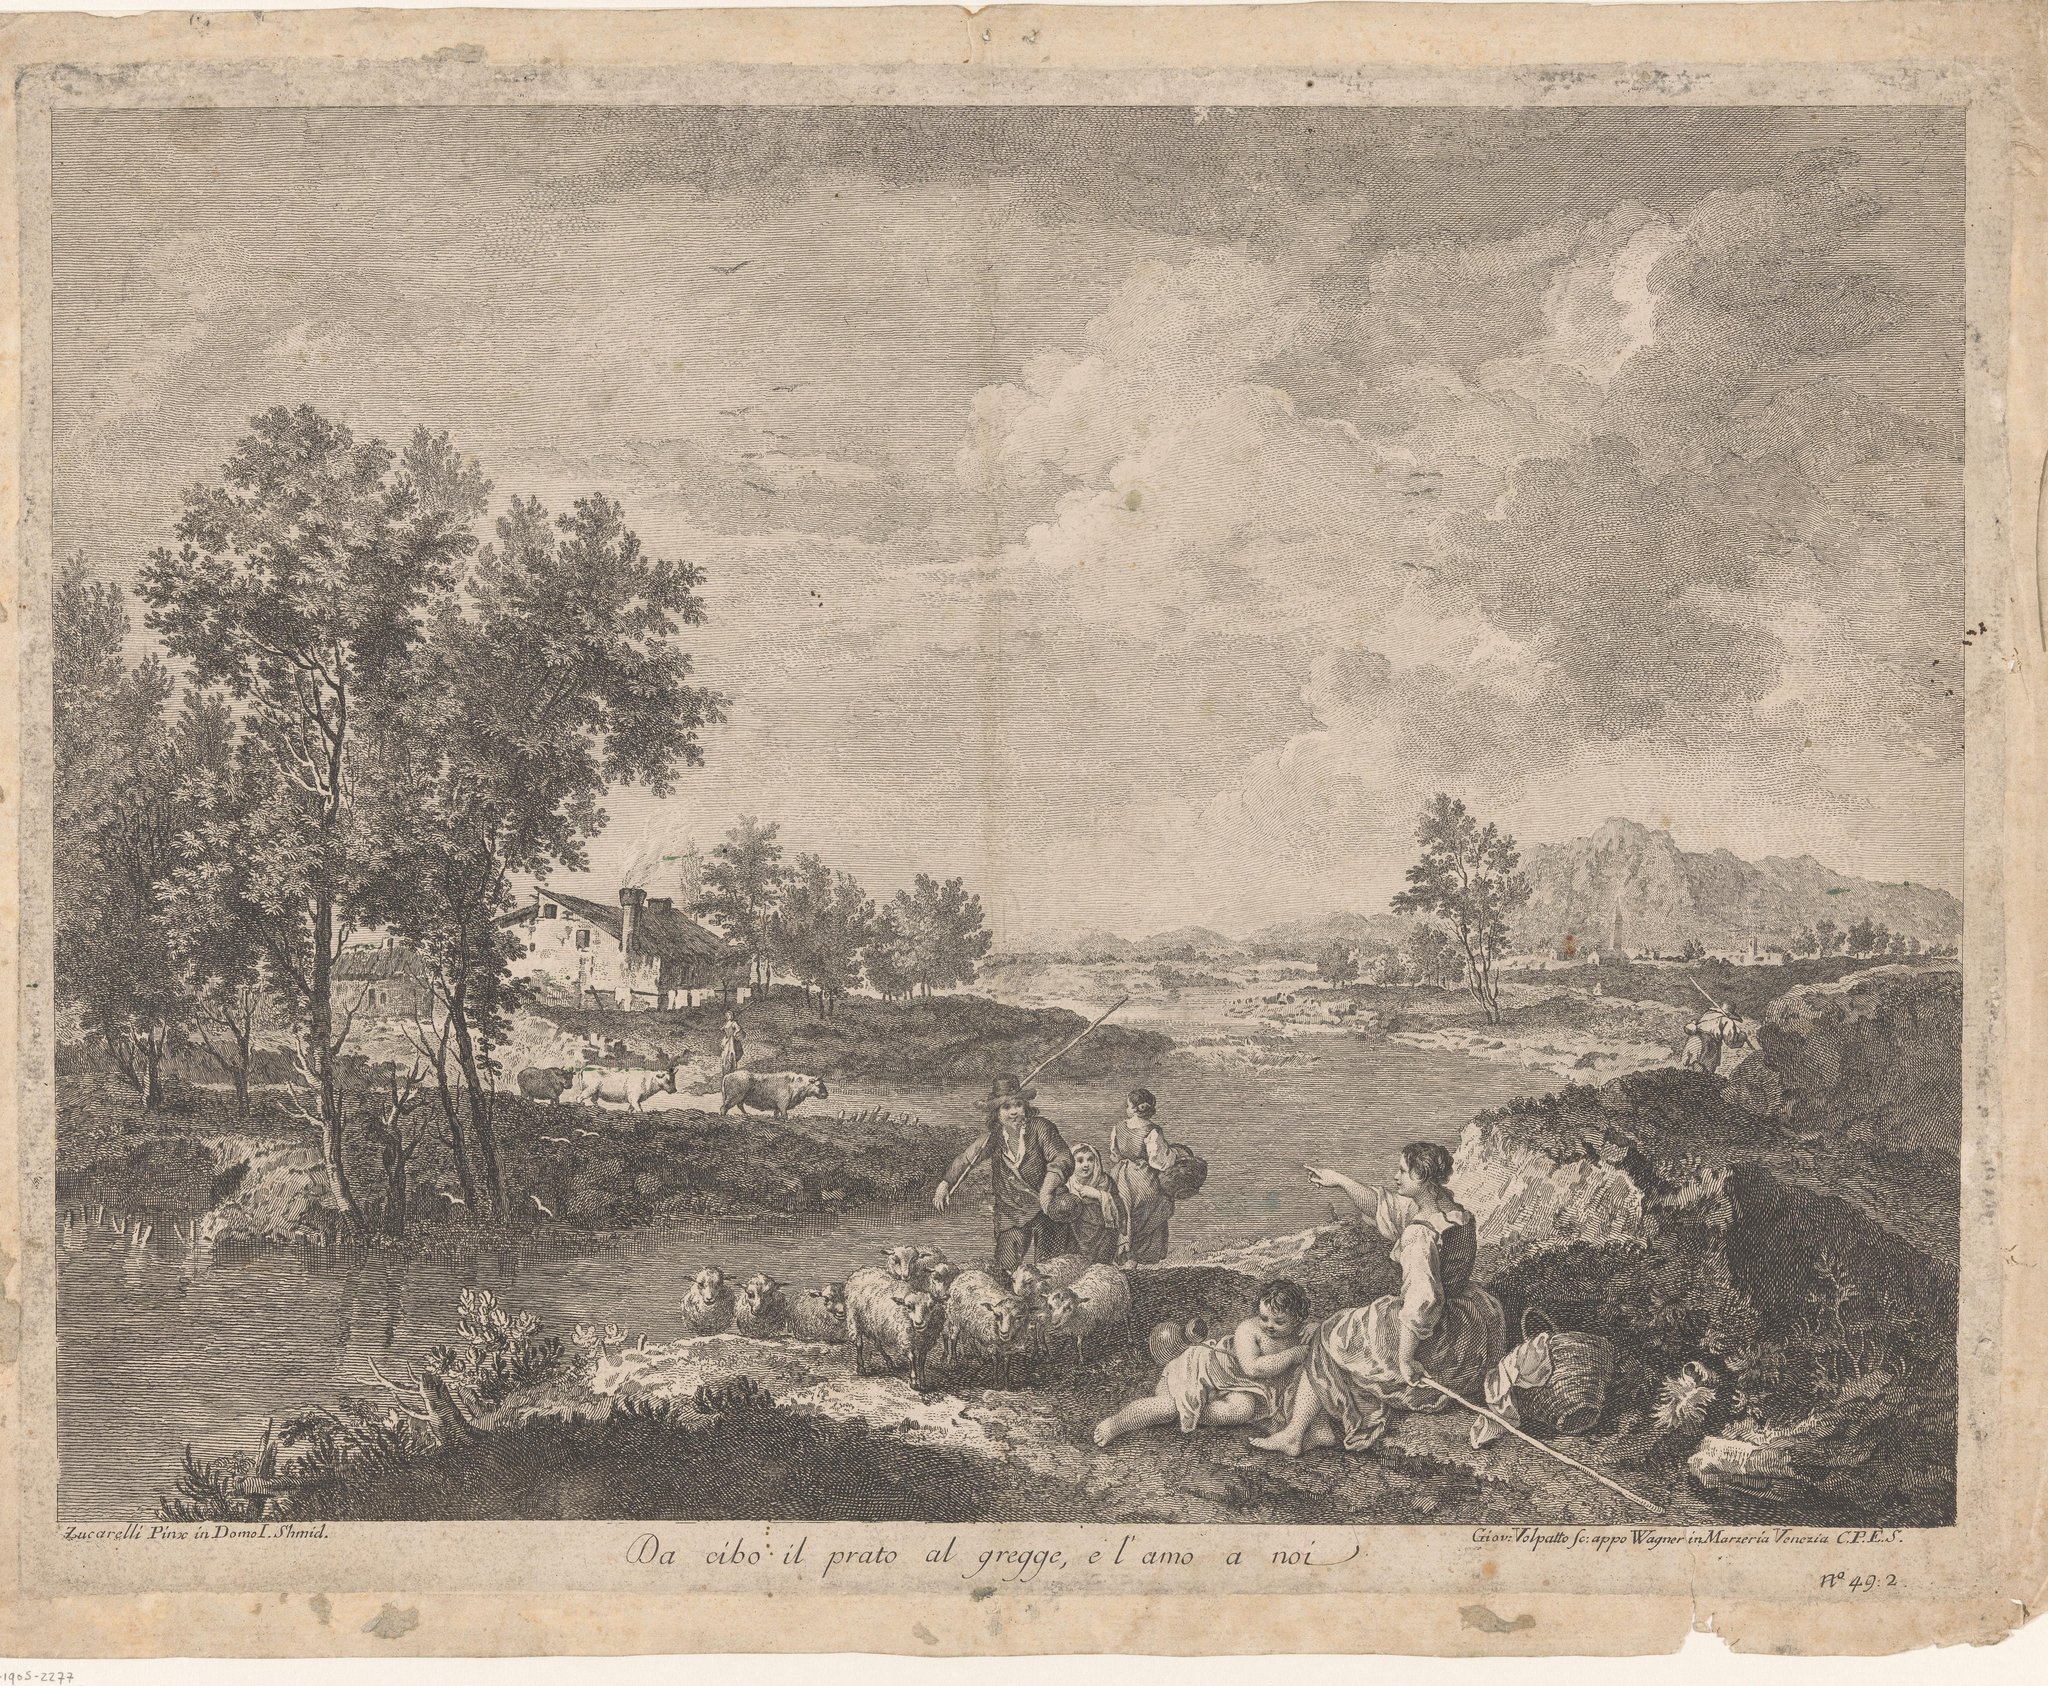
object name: print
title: Da cibo il prato al gregge, e l'amo a noi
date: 1750-1803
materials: paper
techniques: etching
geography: italy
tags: city-view, and landscape with man-made constructions, herd, flock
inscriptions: collector's mark: Lugt 2228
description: Een weids landschap met op de voorgrond herders met een kudde schapen. Genummerd rechtsonder: No 49: 2. Titel in ondermarge.